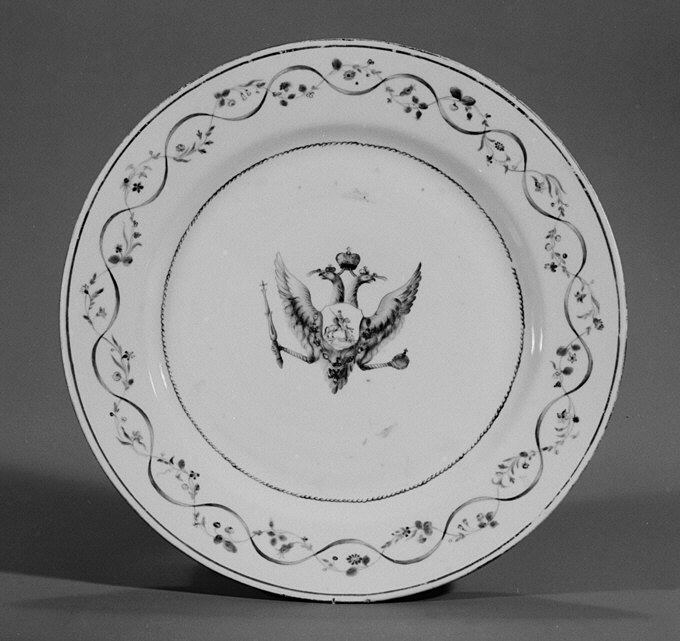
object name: plate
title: Plate (one of two)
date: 1780-1790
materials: hard paste porcelain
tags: human figures,eagles,horses